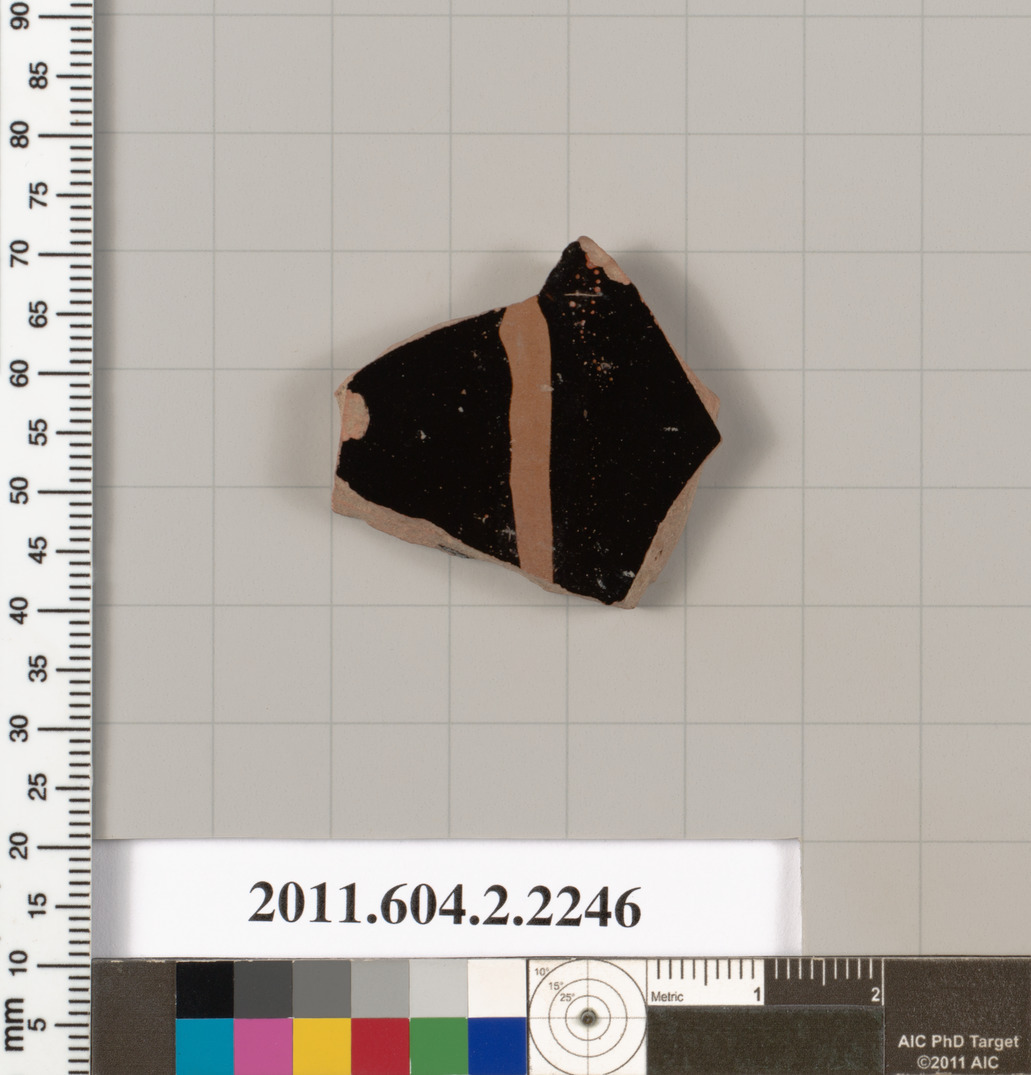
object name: pot fragment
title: Terracotta fragment of a pot; unglazed on the inside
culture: greek, attic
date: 450-401 BCE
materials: terracotta